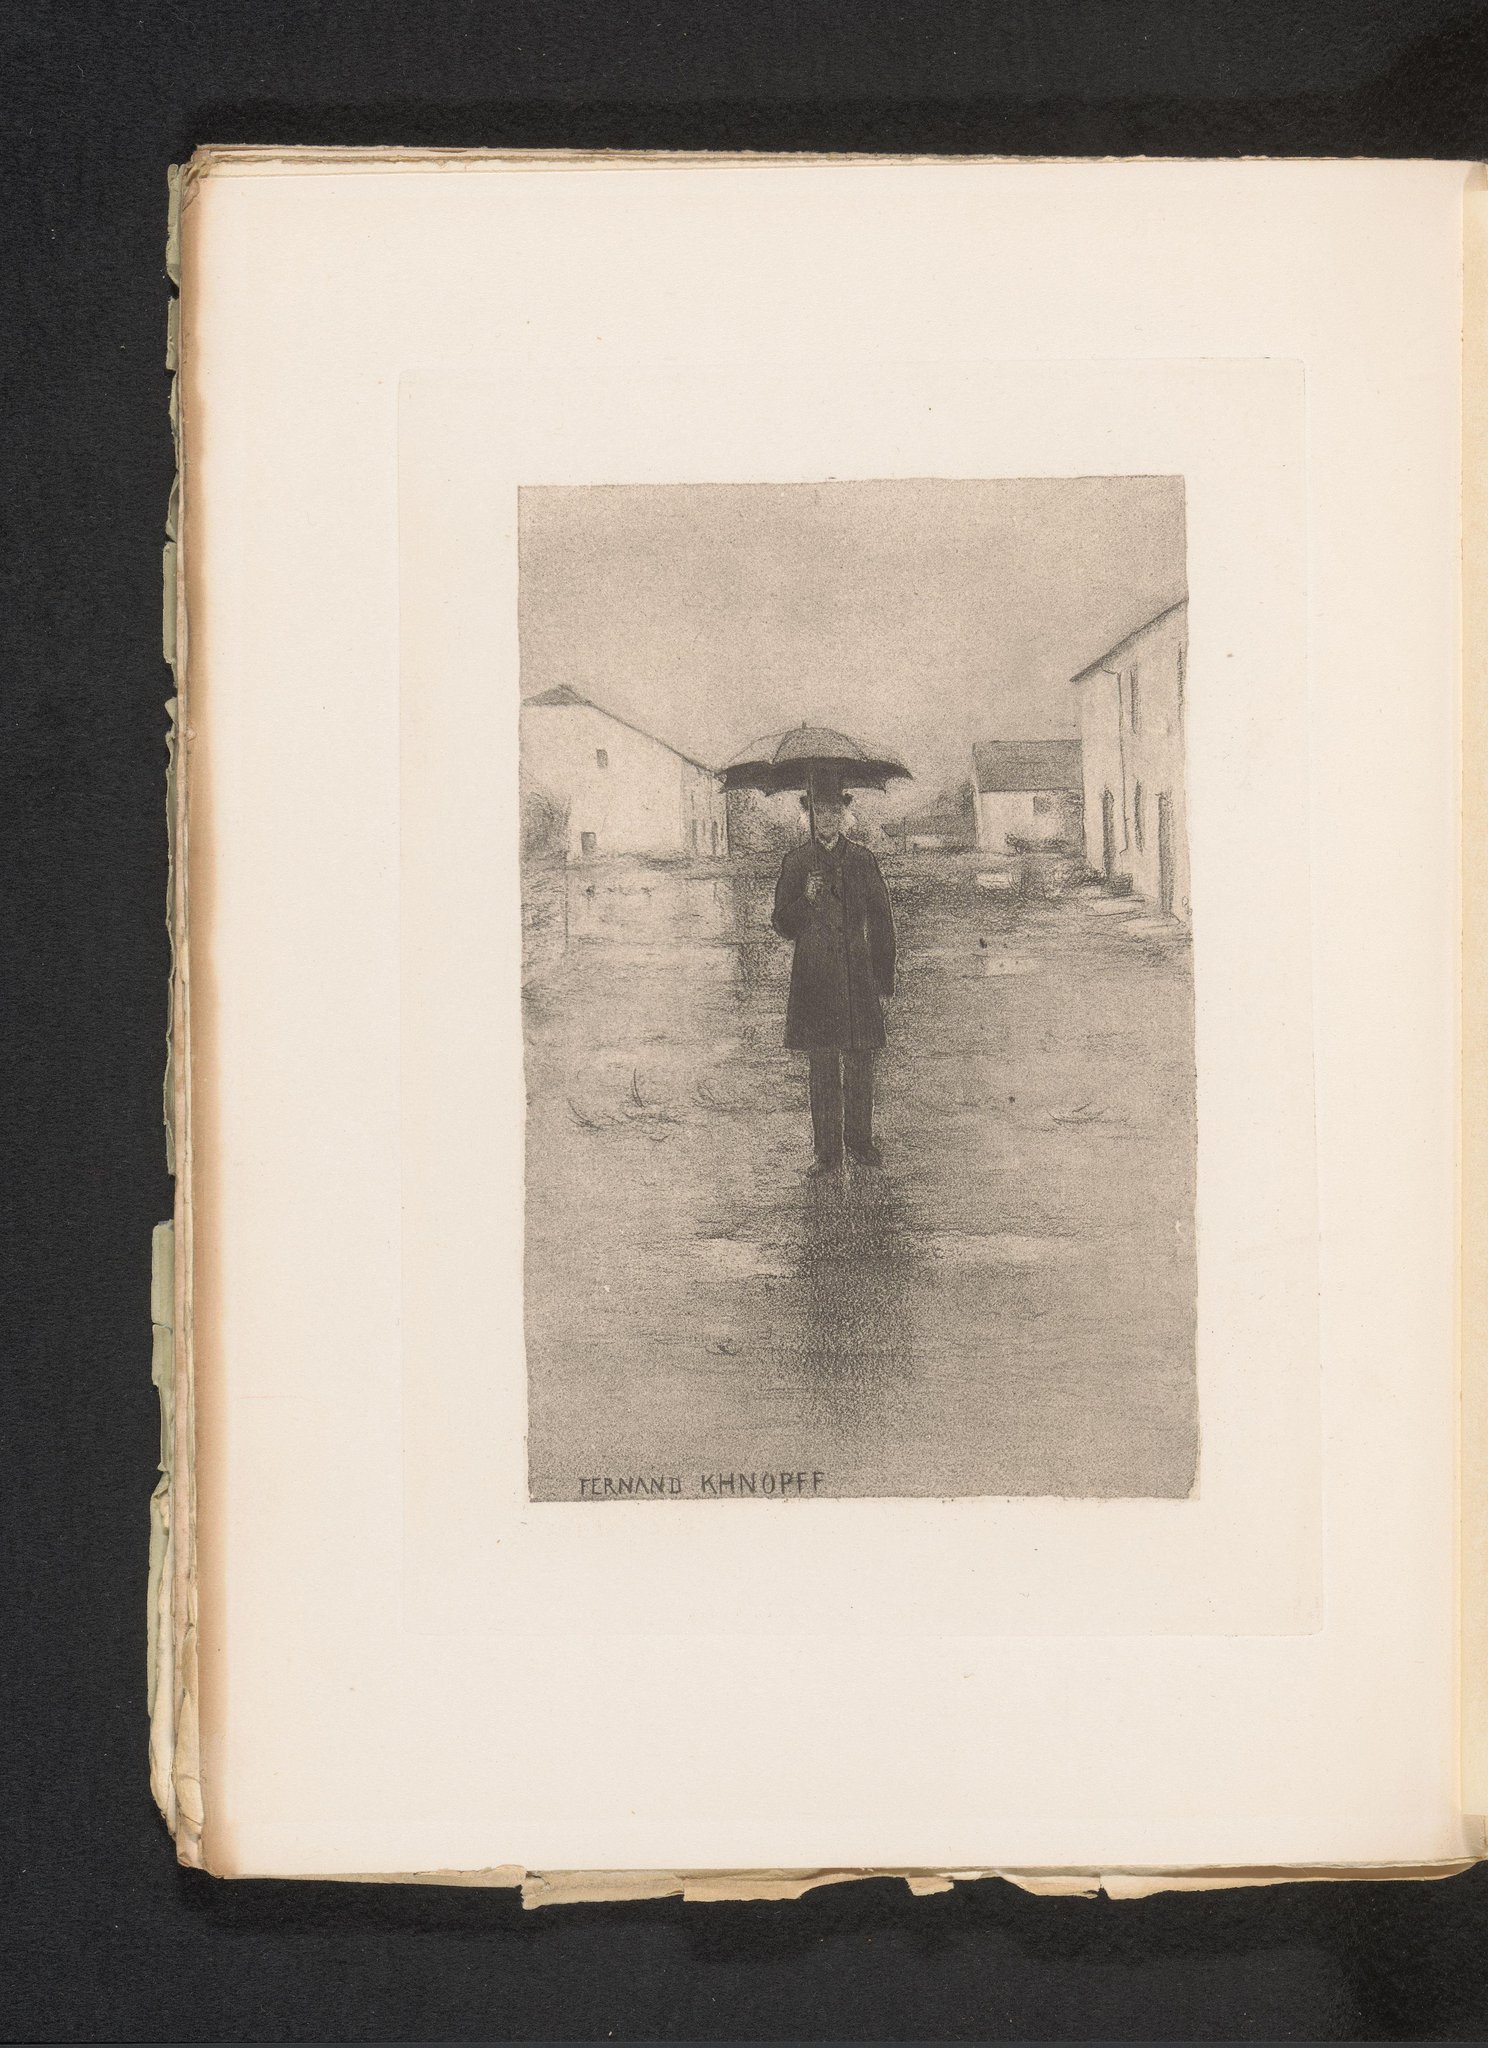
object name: photomechanical print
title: Fotoreproductie naar ontwerp van Le Procureur-Général door Fernand Khnopff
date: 1879-1884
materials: paper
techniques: photoaquatint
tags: historical persons, umbrella, painting, drawing and the graphic arts